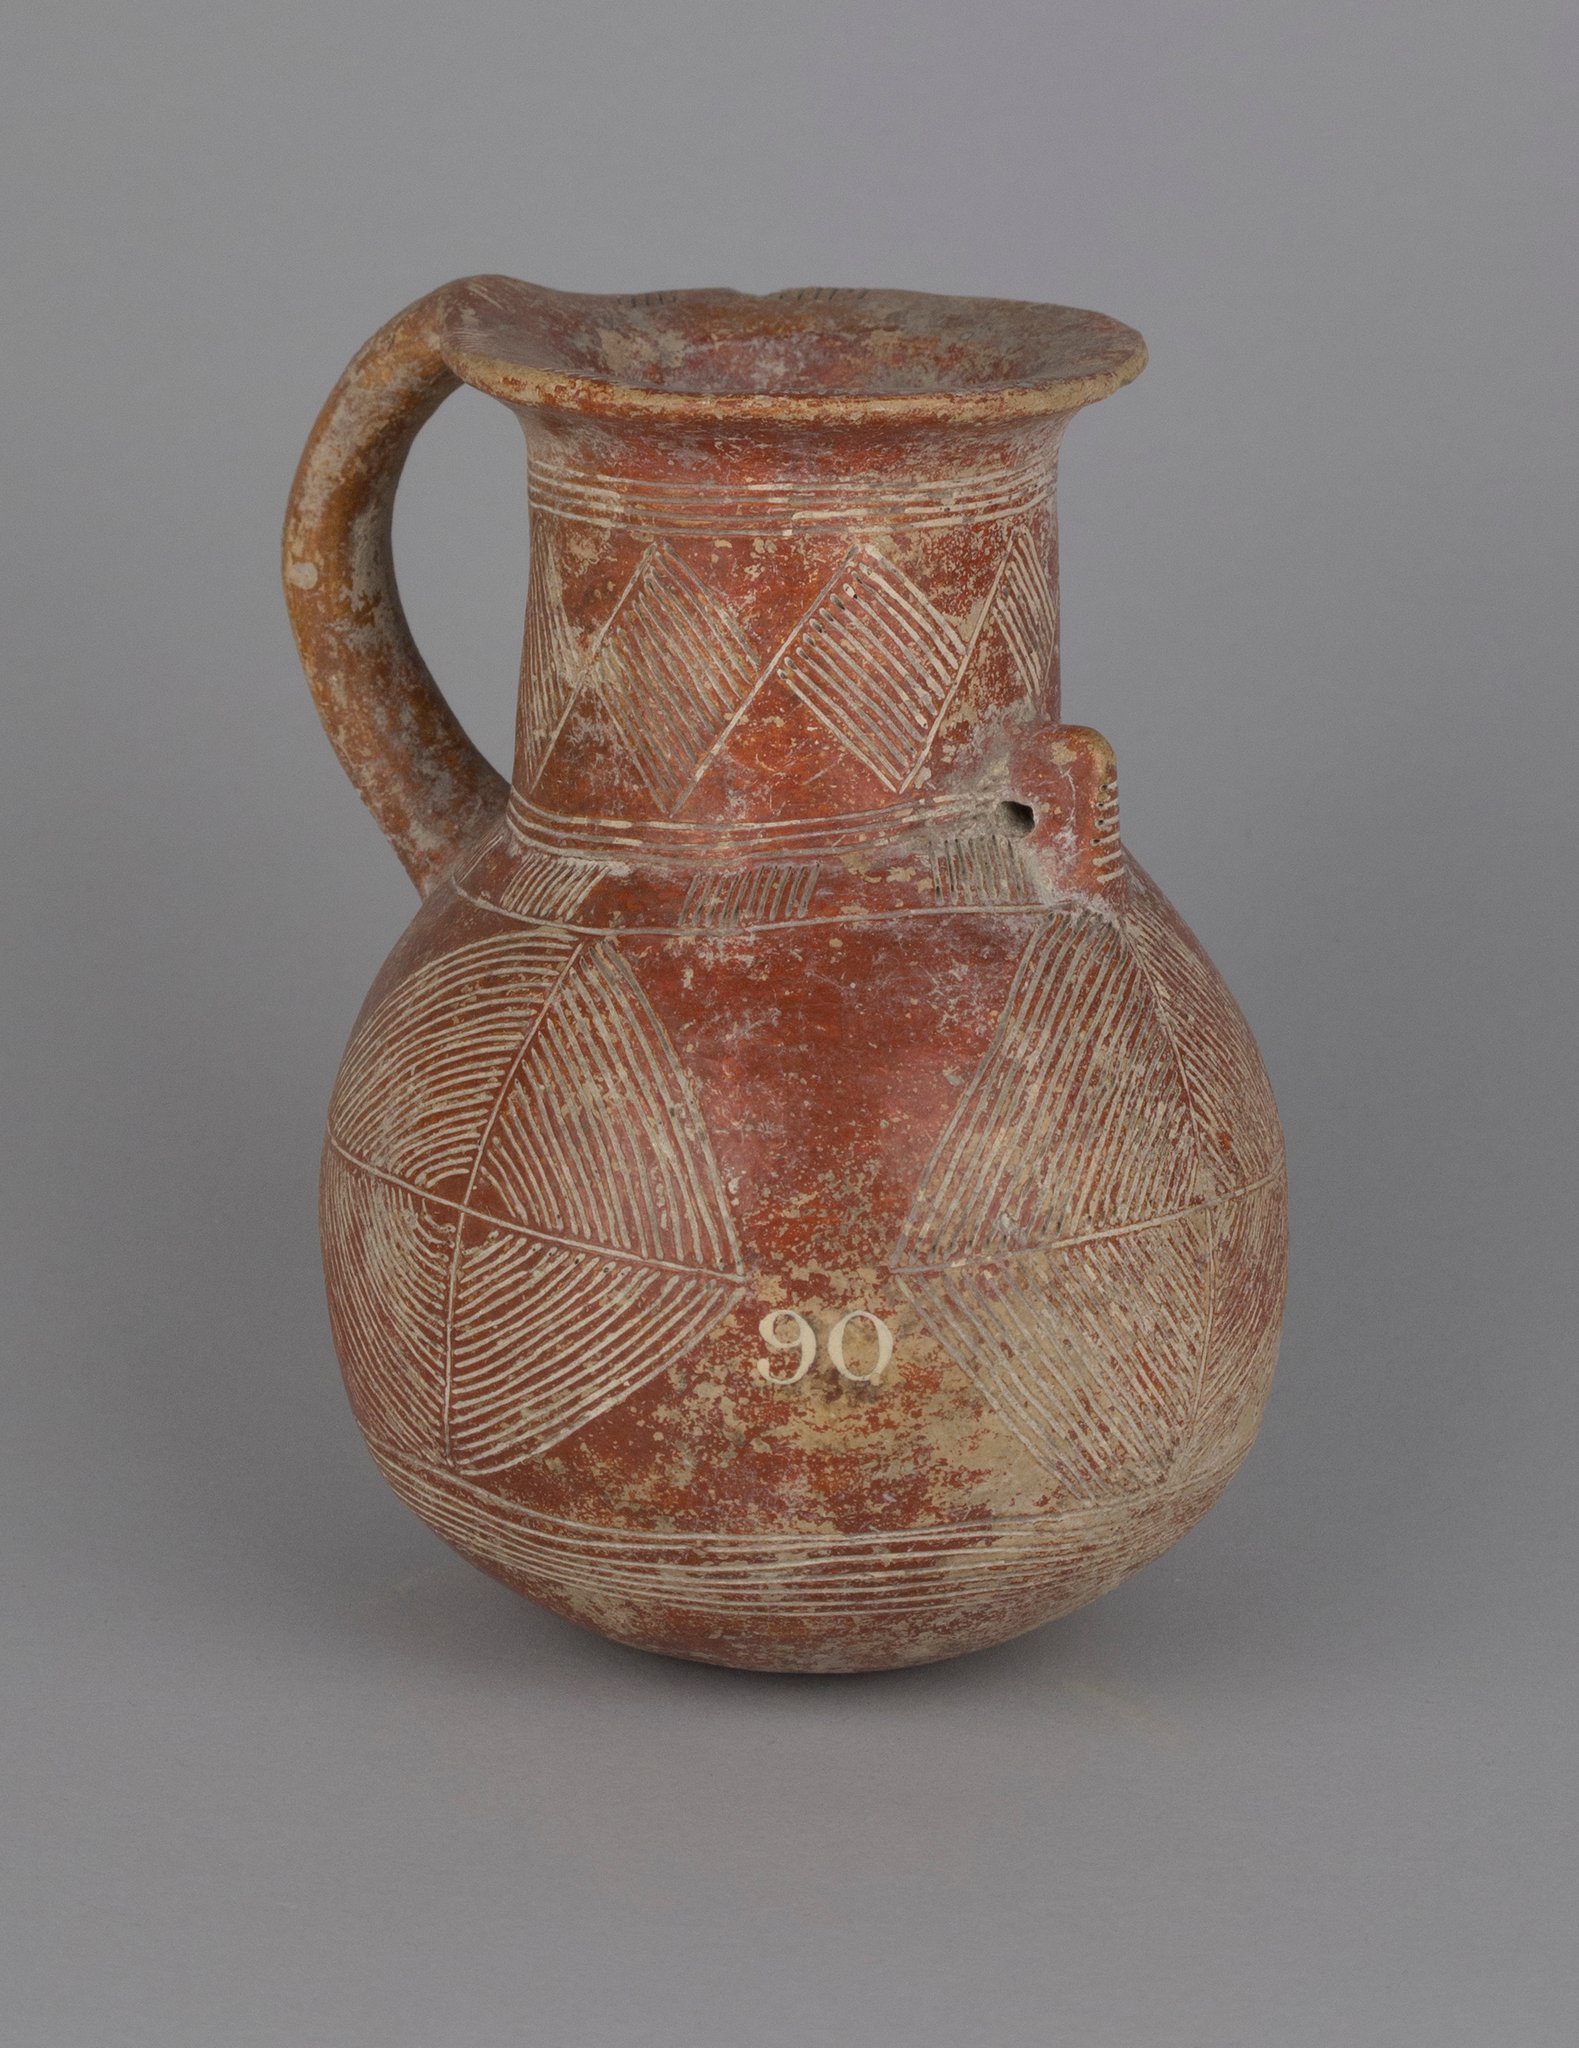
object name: jug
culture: cypriot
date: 2500-1900 BCE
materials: terracotta